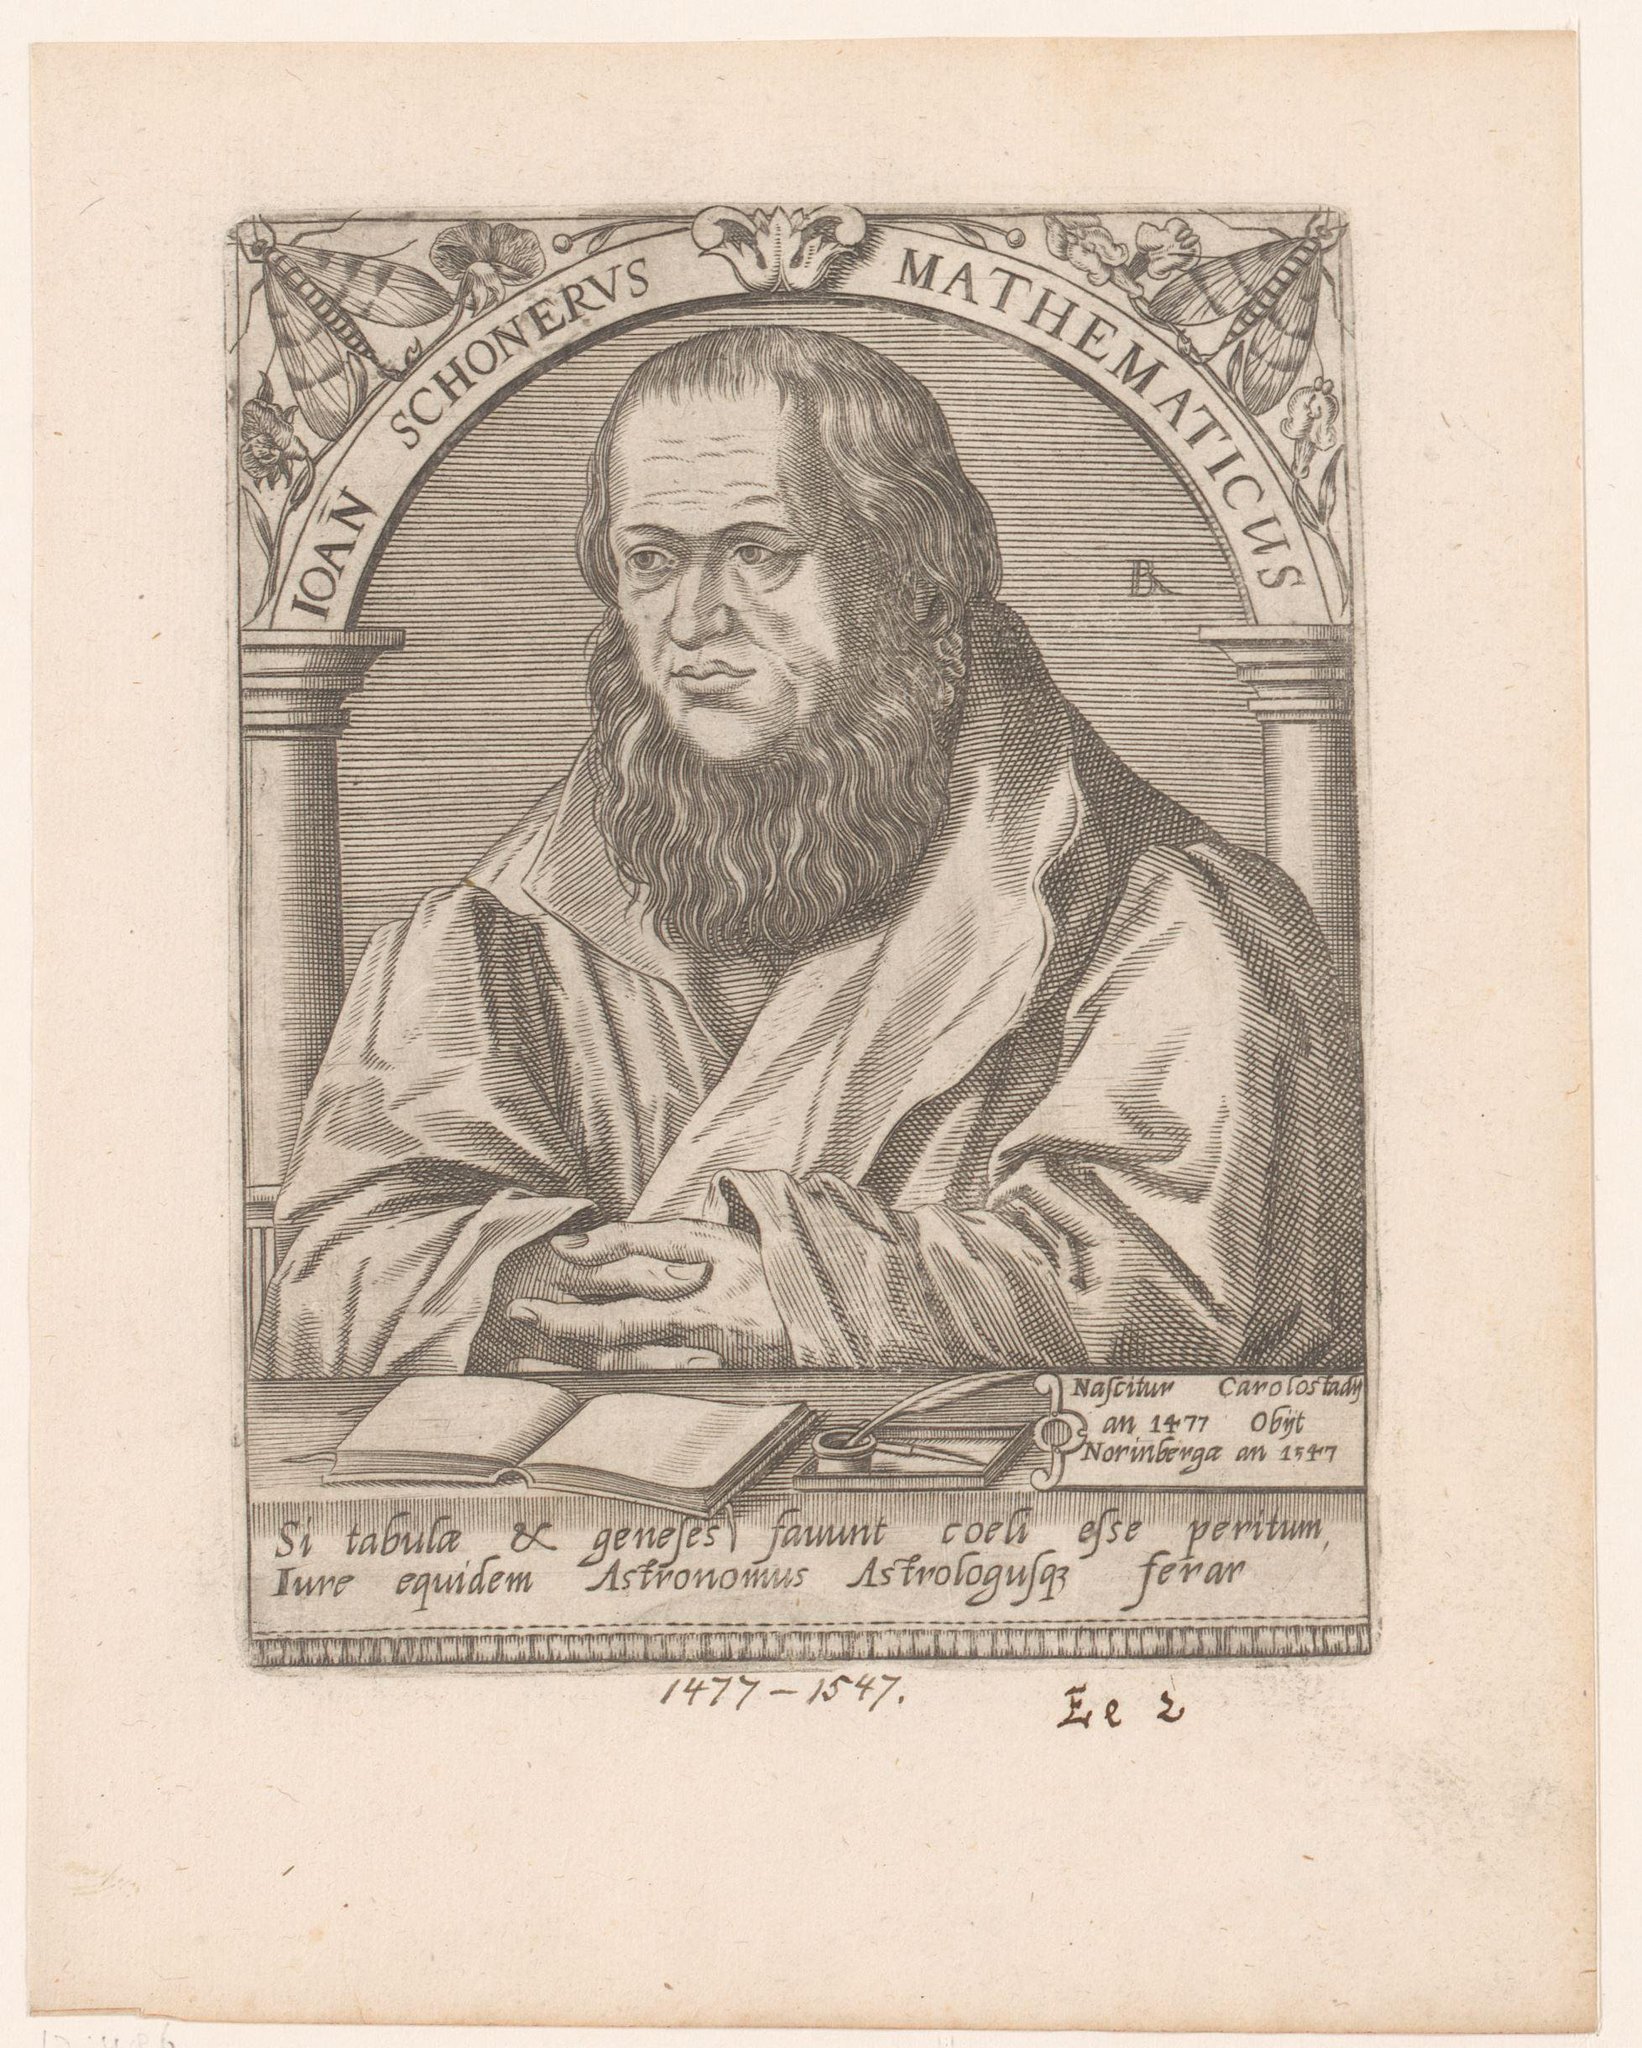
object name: print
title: Joan Schonerus mathematicus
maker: robert boissard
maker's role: print maker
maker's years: 1570-1611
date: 1597-1599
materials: paper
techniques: engraving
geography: france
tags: ink-well, historical persons, book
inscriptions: collector's mark: Lugt 2228, inscription: ‘1477-1547. Ee2’